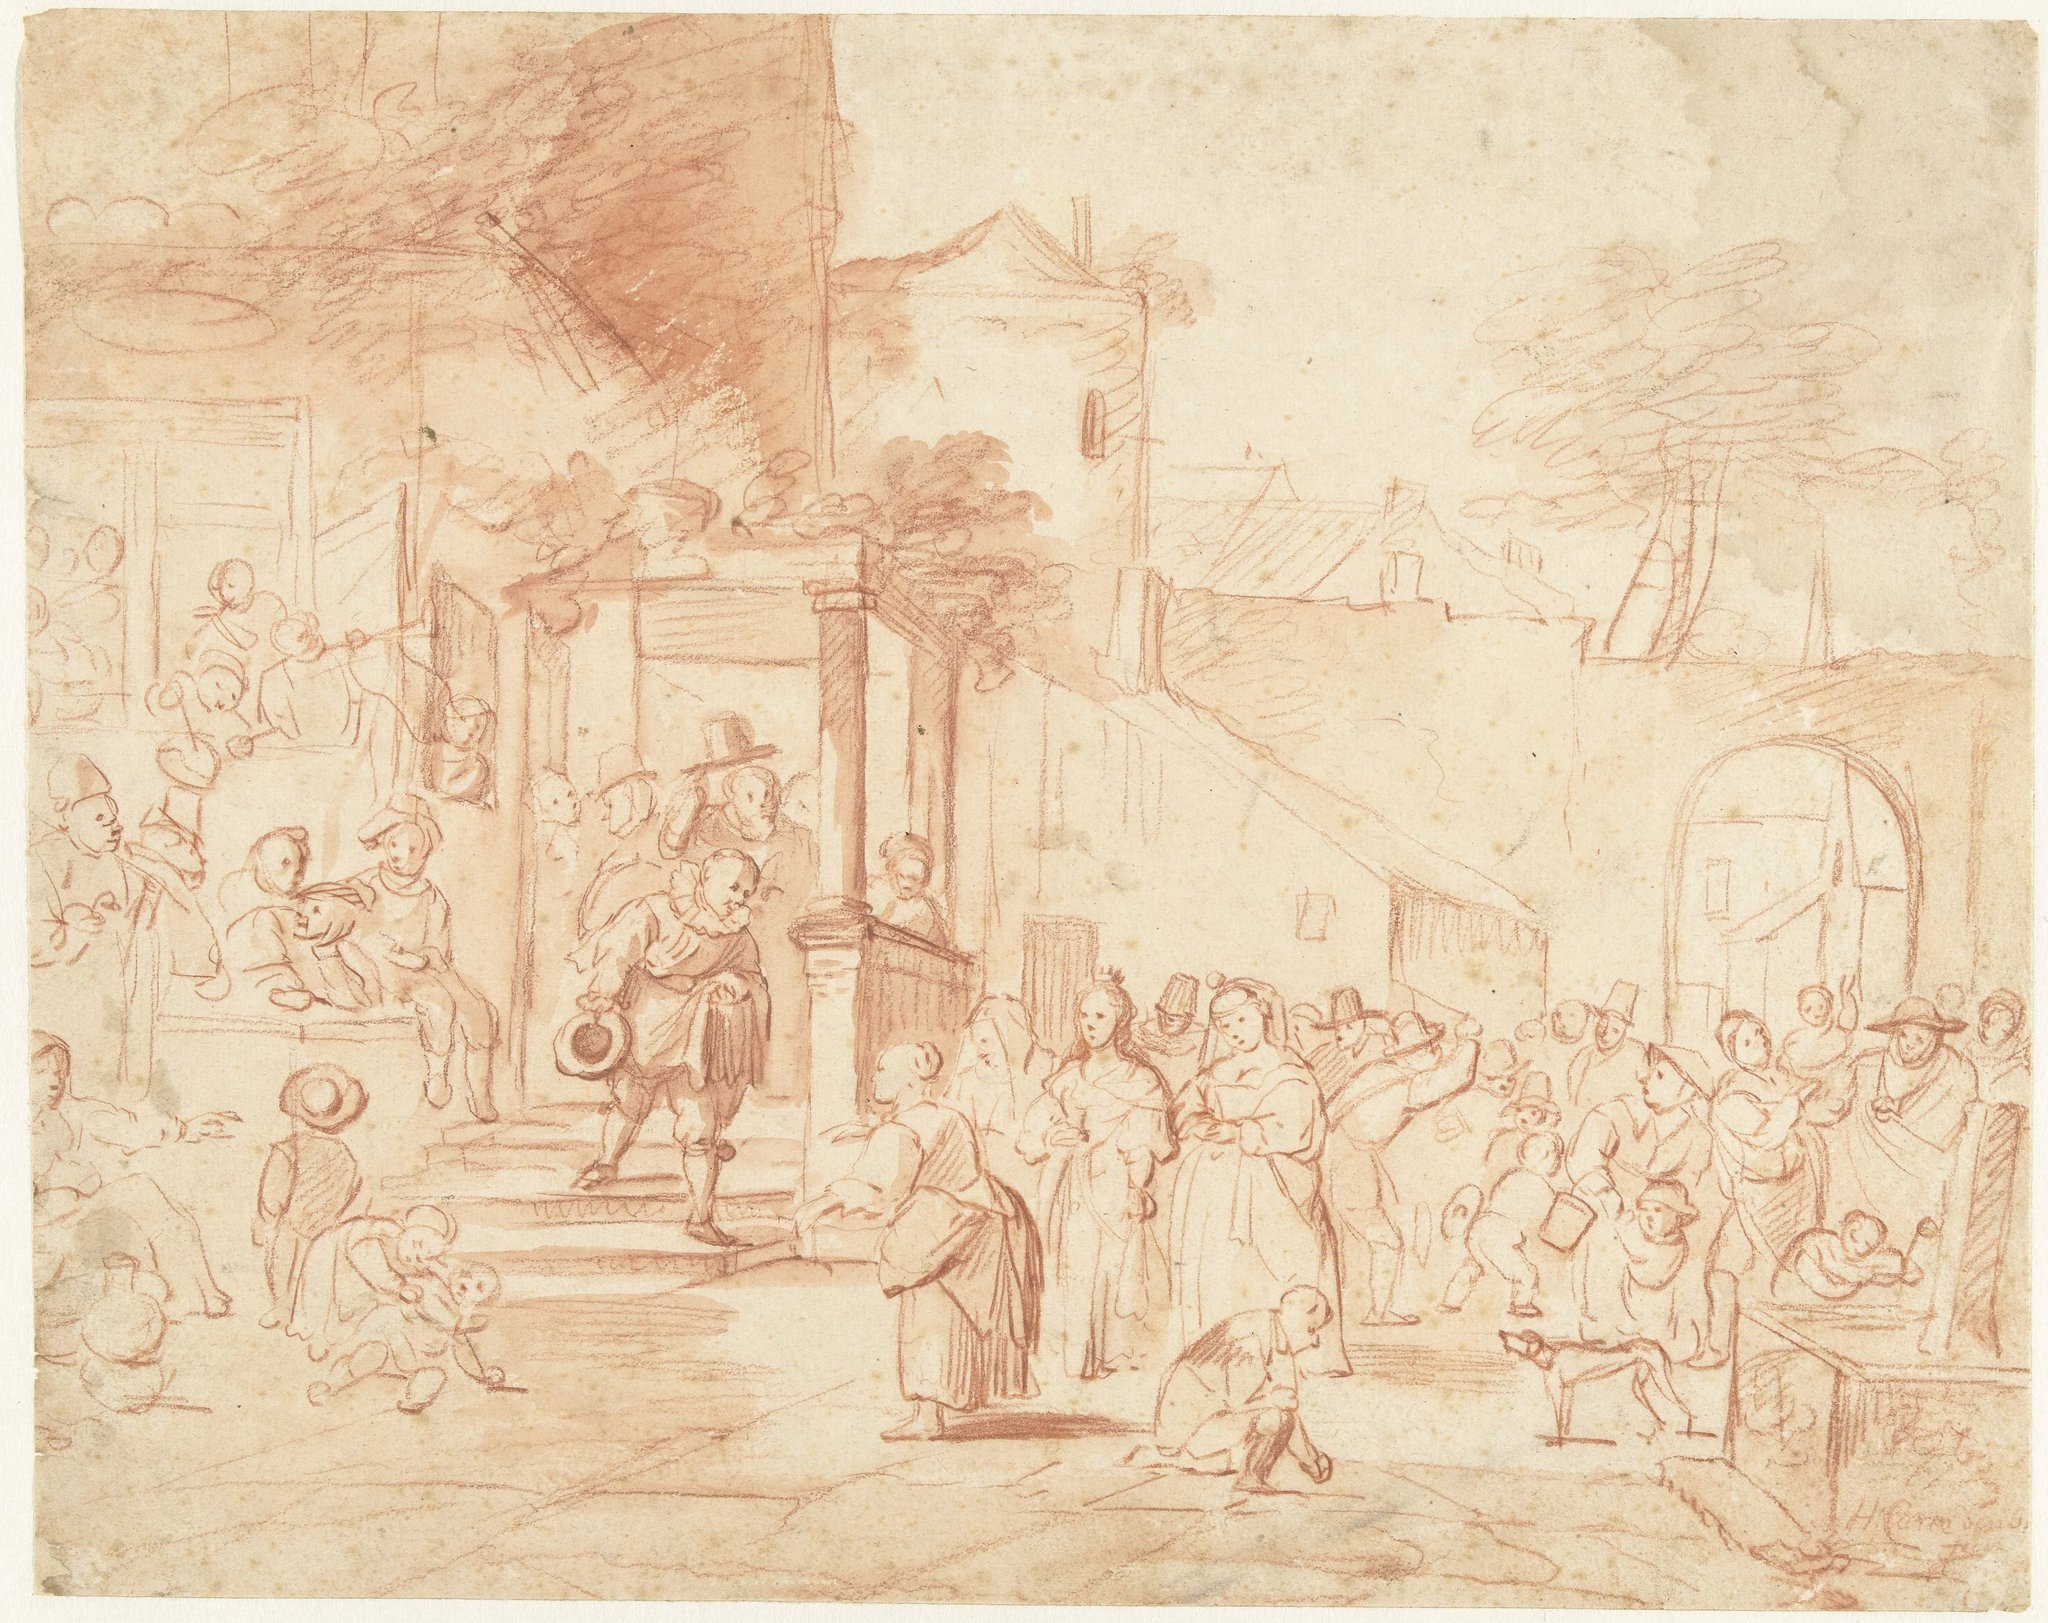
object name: drawing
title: De Dorpsbruiloft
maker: hendrik carré (ii)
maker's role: draughtsman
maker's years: 1696-1775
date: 1775-1799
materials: chalk, paper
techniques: brush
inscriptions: annotation: ‘No. 3. i’, signature and date: ‘H.Carre den 6 [afgesneden]’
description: Kopie naar "De Dorpsbruiloft" door Jan Steen. Schilderij in Museum Boijmans, bruikleen van ICN.